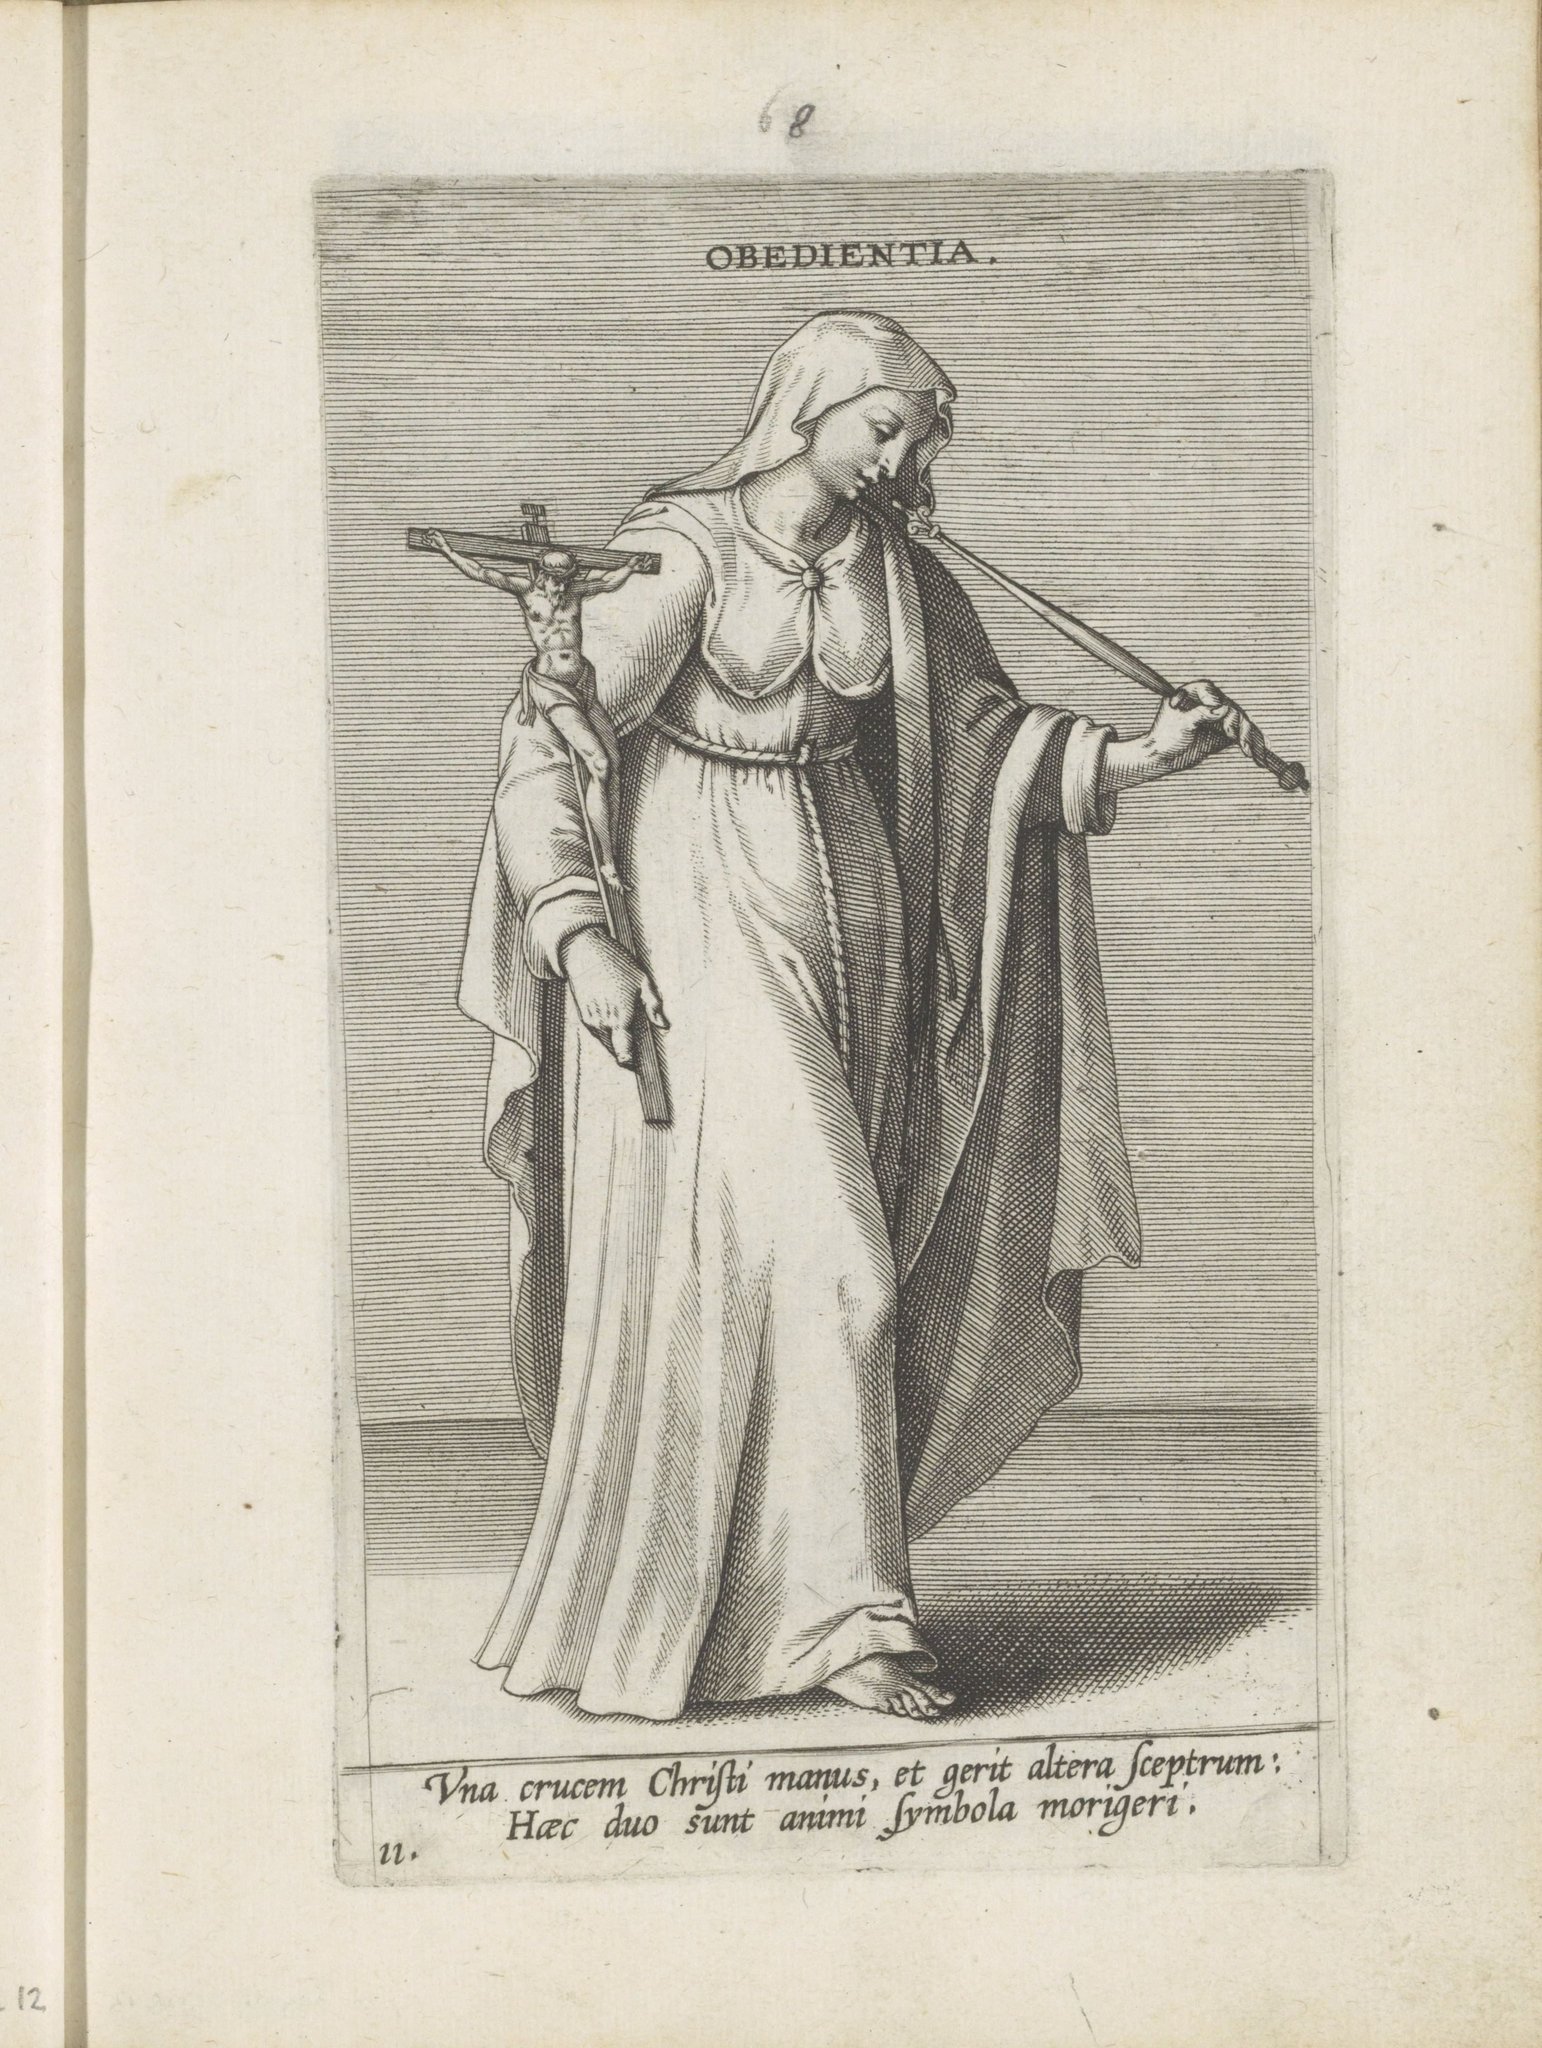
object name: album leaf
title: Prosopographia, sive virtutum, animi, corporis, bonorum externorum, vitiorum, et affectuum variorum delineatio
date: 1585-1590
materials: paper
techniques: engraving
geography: southern netherlands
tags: 'obedienza verso dio' (ripa), obedience; 'obedienza' (ripa)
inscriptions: collector's mark: Lugt 2760, collector's mark: Lugt 2228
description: Een vrouw buigt nederig haar hoofd. In haar linkerhand heeft ze een scepter, op haar rechterarm een Crucifix. Christus gehoorzaamde zijn Vader door te sterven voor de Mensheid. Onder de voorstelling twee regels tekst in het Latijn. De prent maakt deel uit van een album.